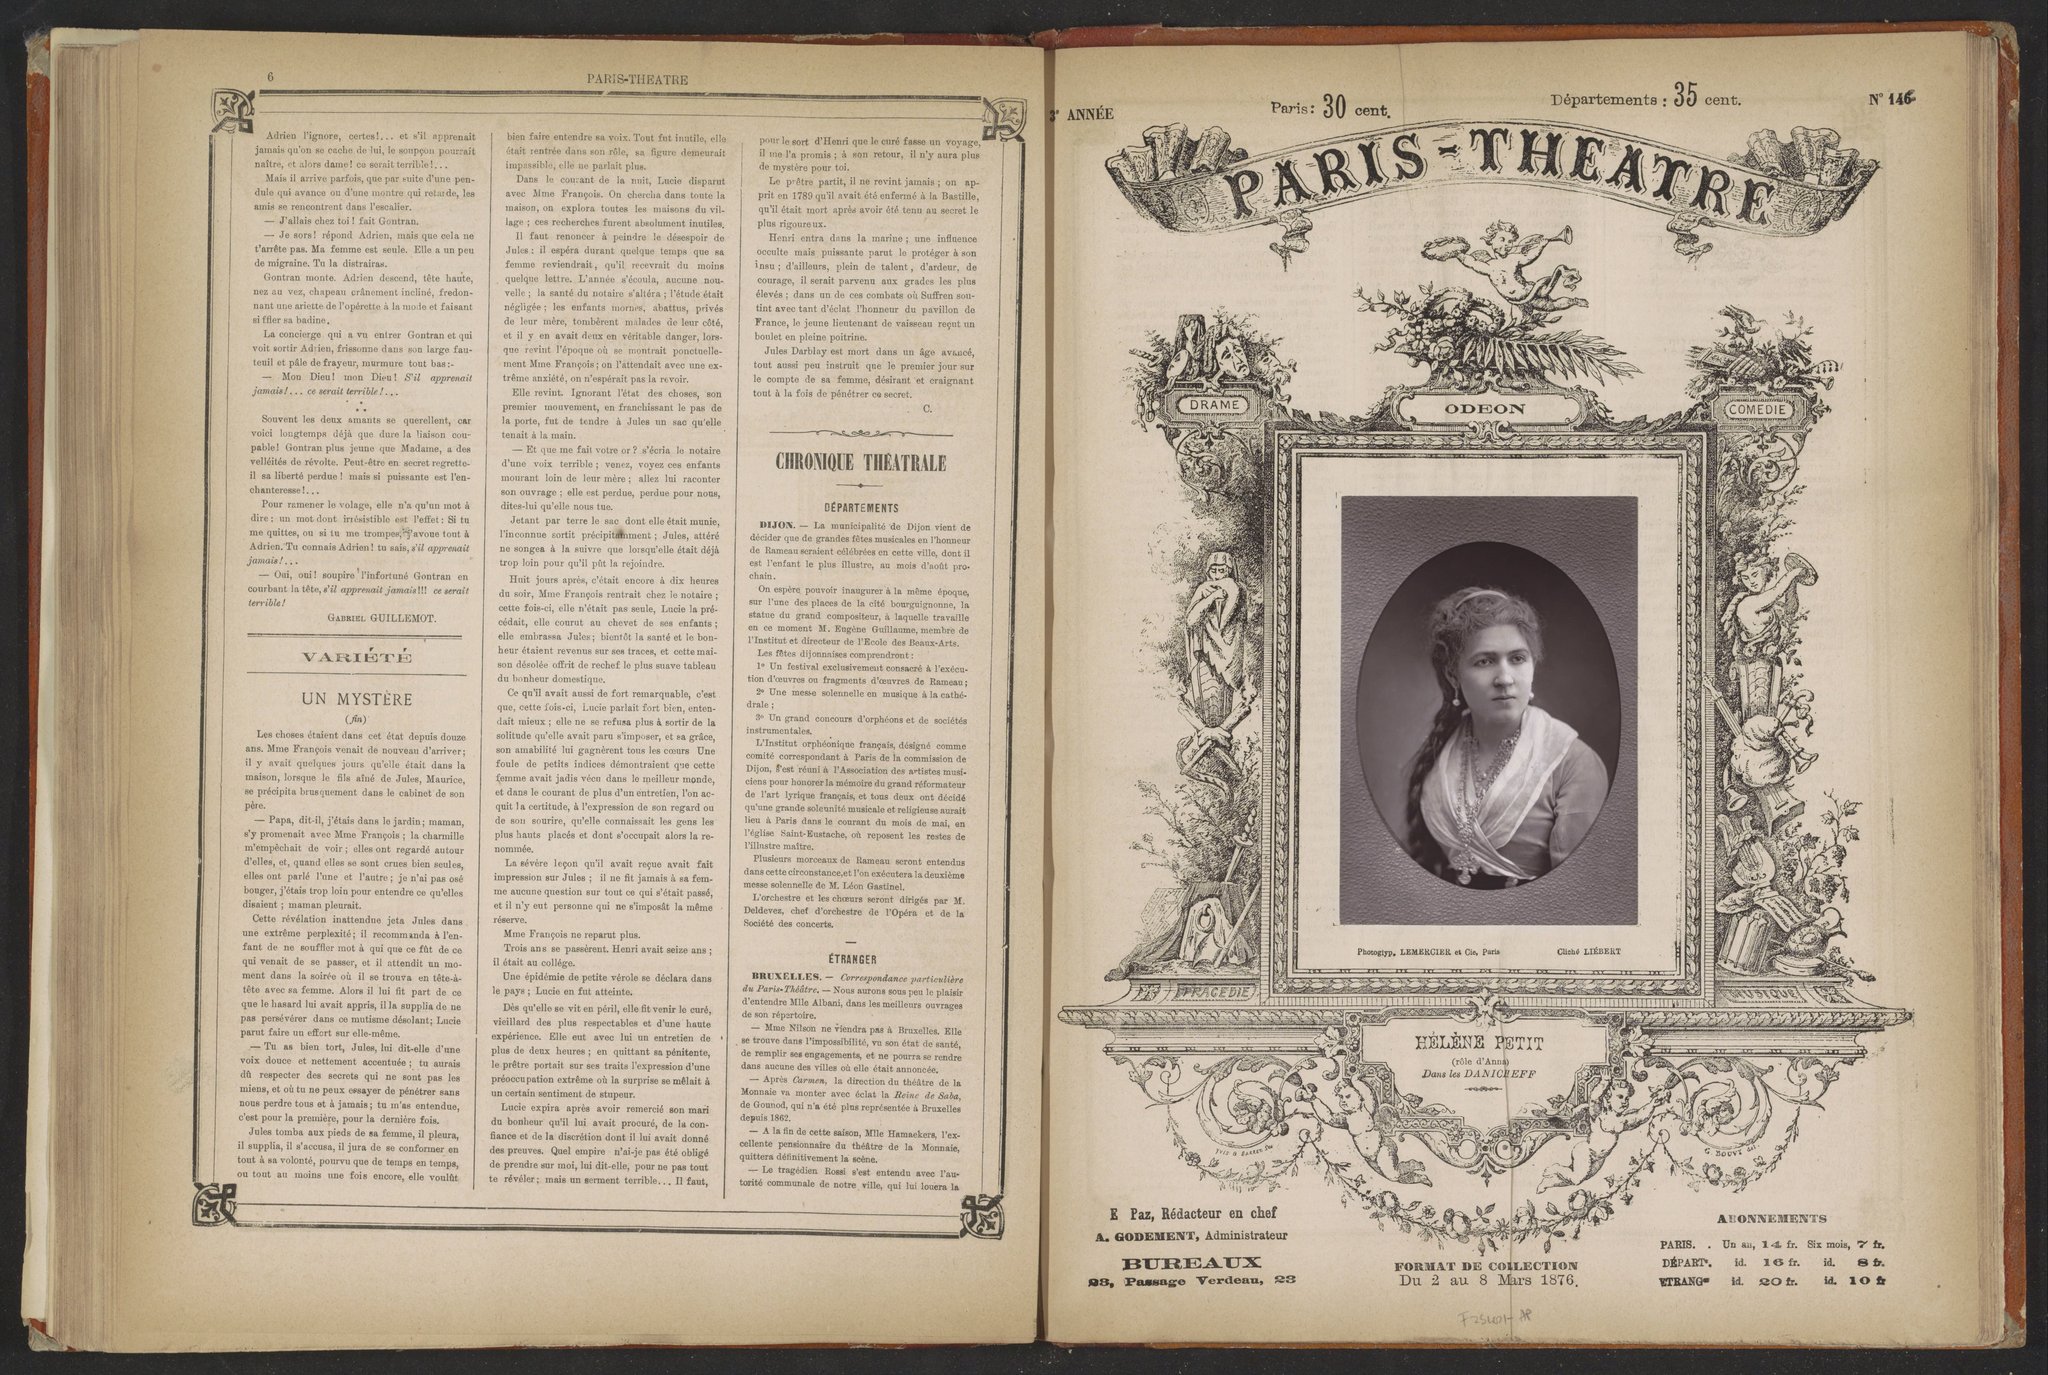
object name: photomechanical print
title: Portret van Hélène Petit als Anne in Les Danicheff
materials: paper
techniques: woodburytype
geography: france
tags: portrait of actor, actress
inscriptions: number: ‘No 146’, inscription: ‘Du 2 au 8 Mars 1876.’